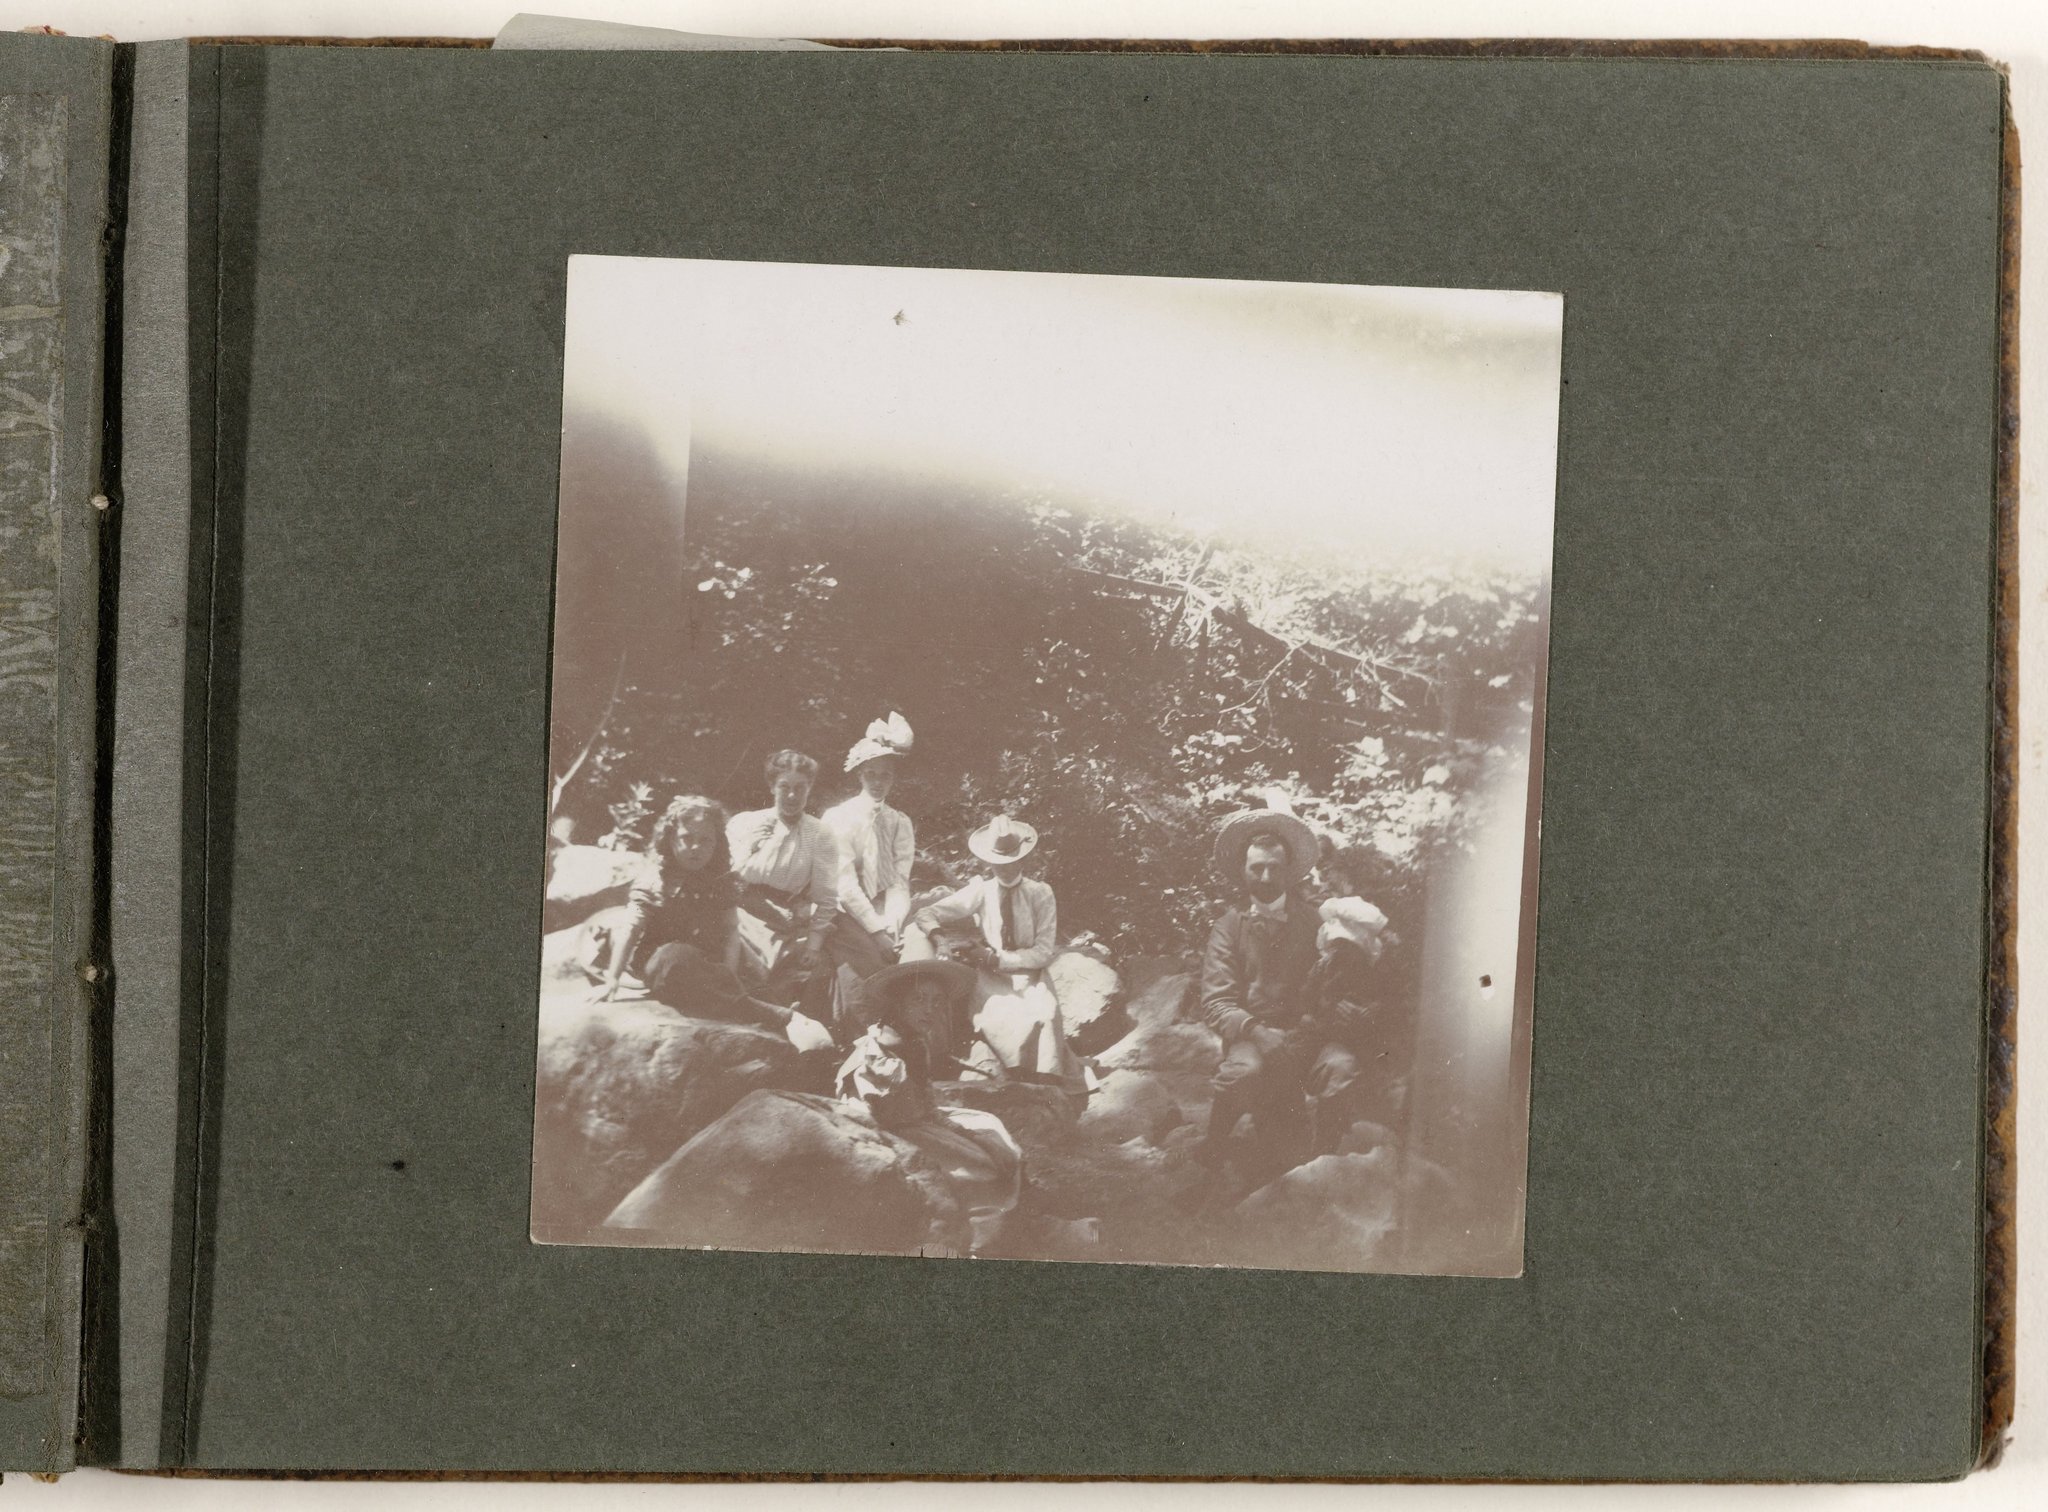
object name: album leaf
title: Groepsportret van een gezelschap op rotsen, Verenigde Staten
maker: Anonymous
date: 1900-1920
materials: paper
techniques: gelatin silver print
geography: united states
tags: rock-formations, anonymous historical persons portrayed in a group, in a group-portrait, united states of america